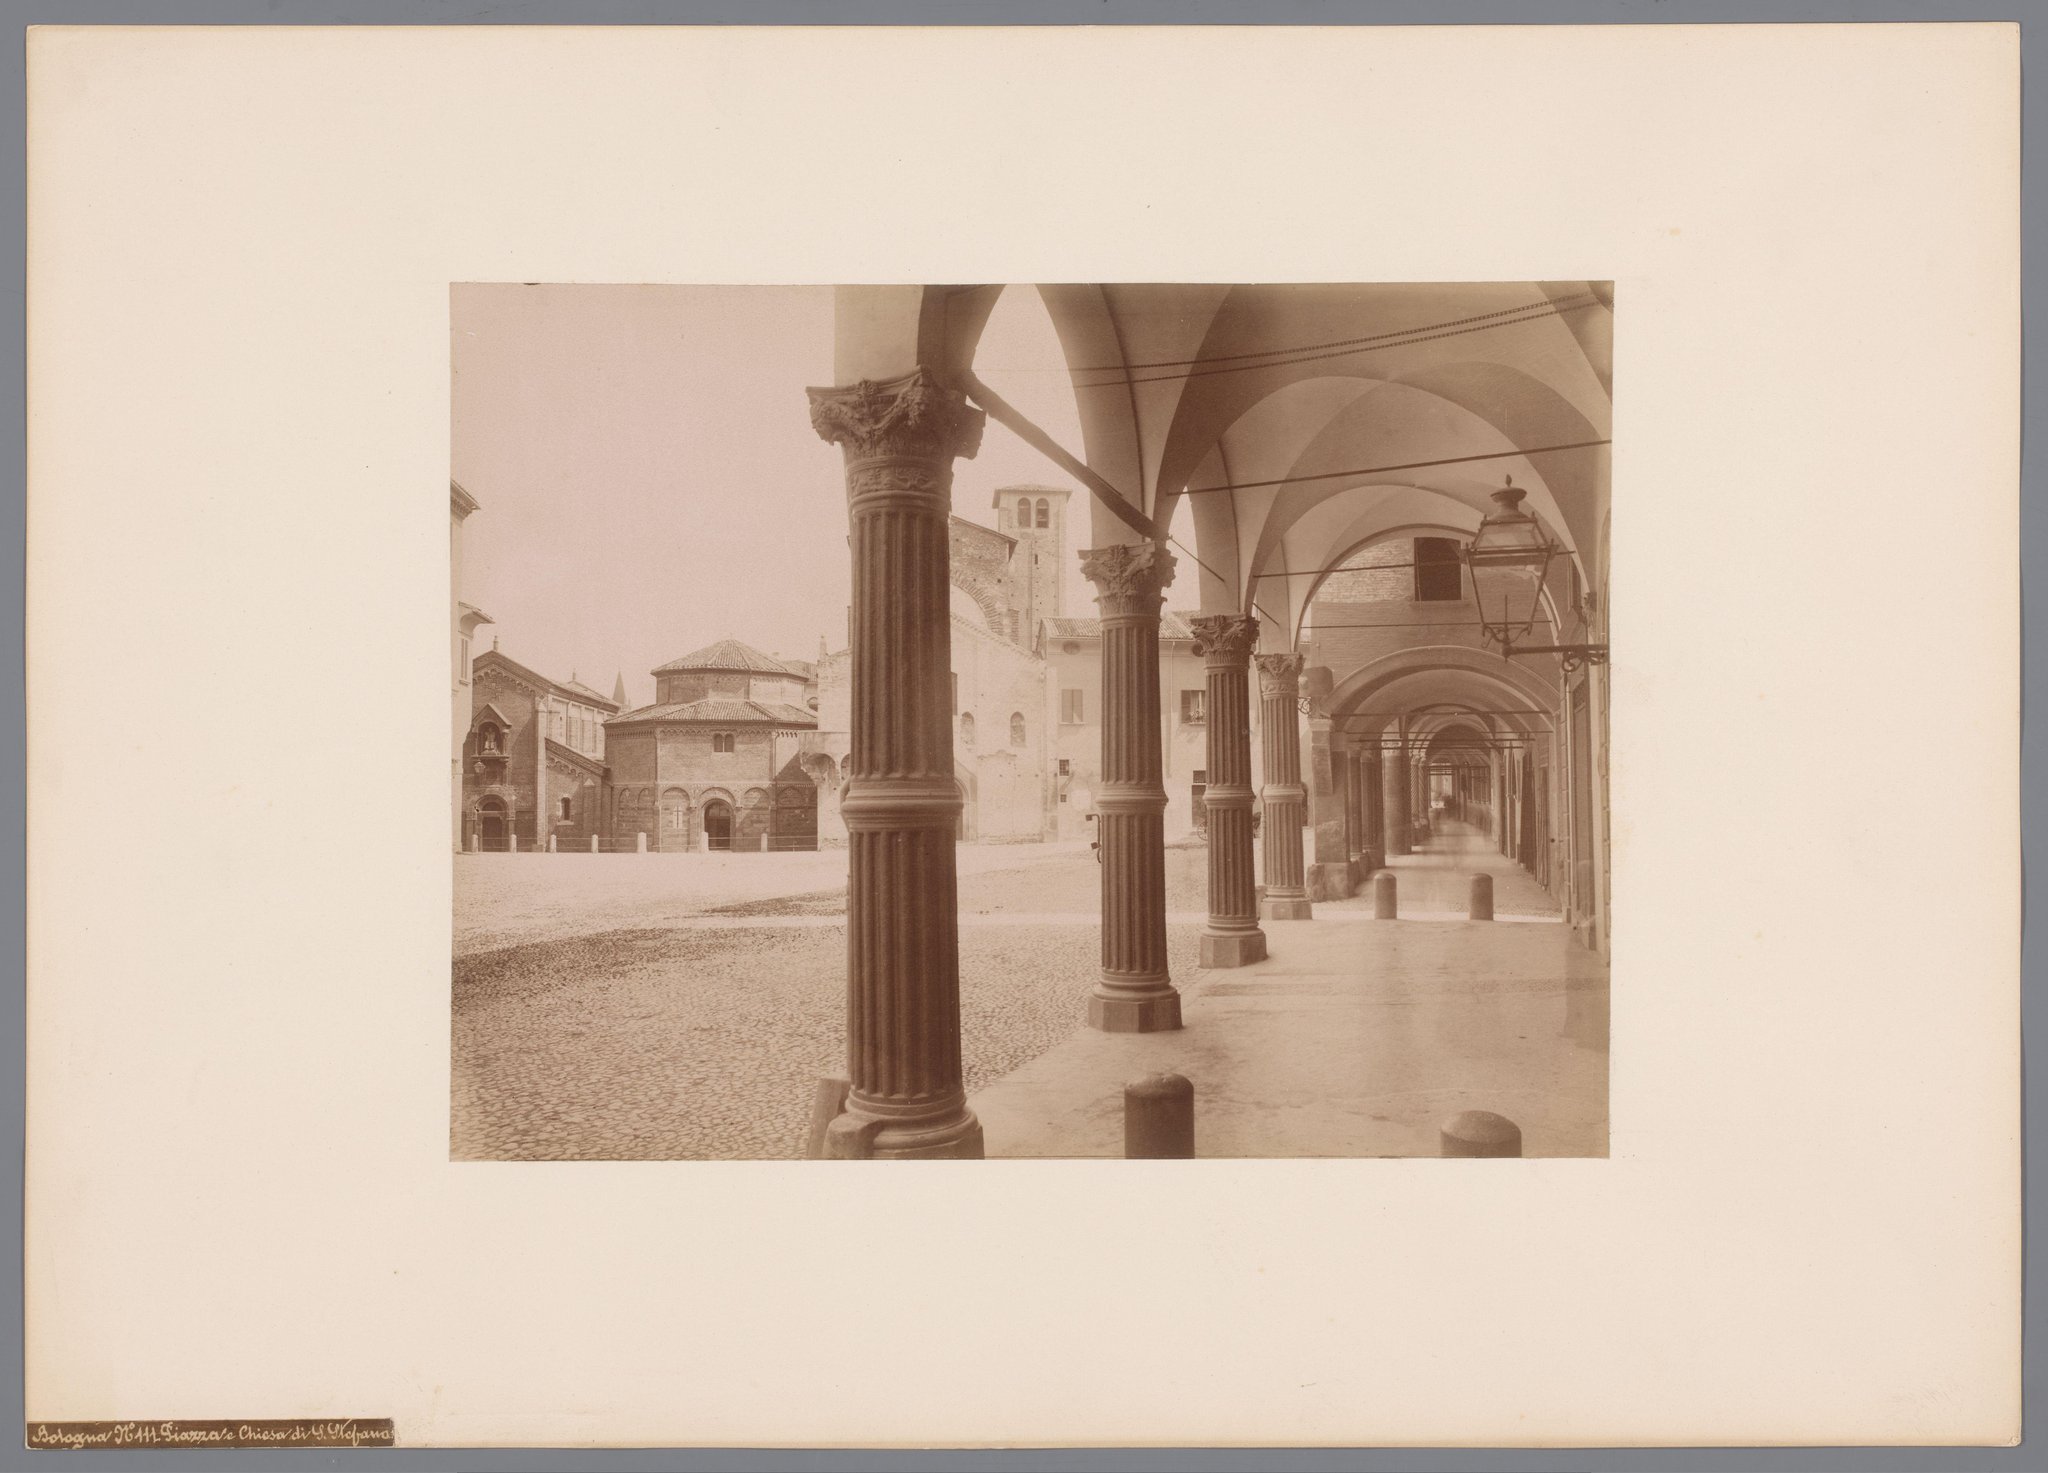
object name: photograph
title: Piazza e Chiesa di S. Stefano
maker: Anonymous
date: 1851-1890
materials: cardboard, paper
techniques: albumen print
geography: bologna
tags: square, place, circus, etc., gallery (spacious corridor)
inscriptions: number: ‘No. 111’, inscription: ‘an.’